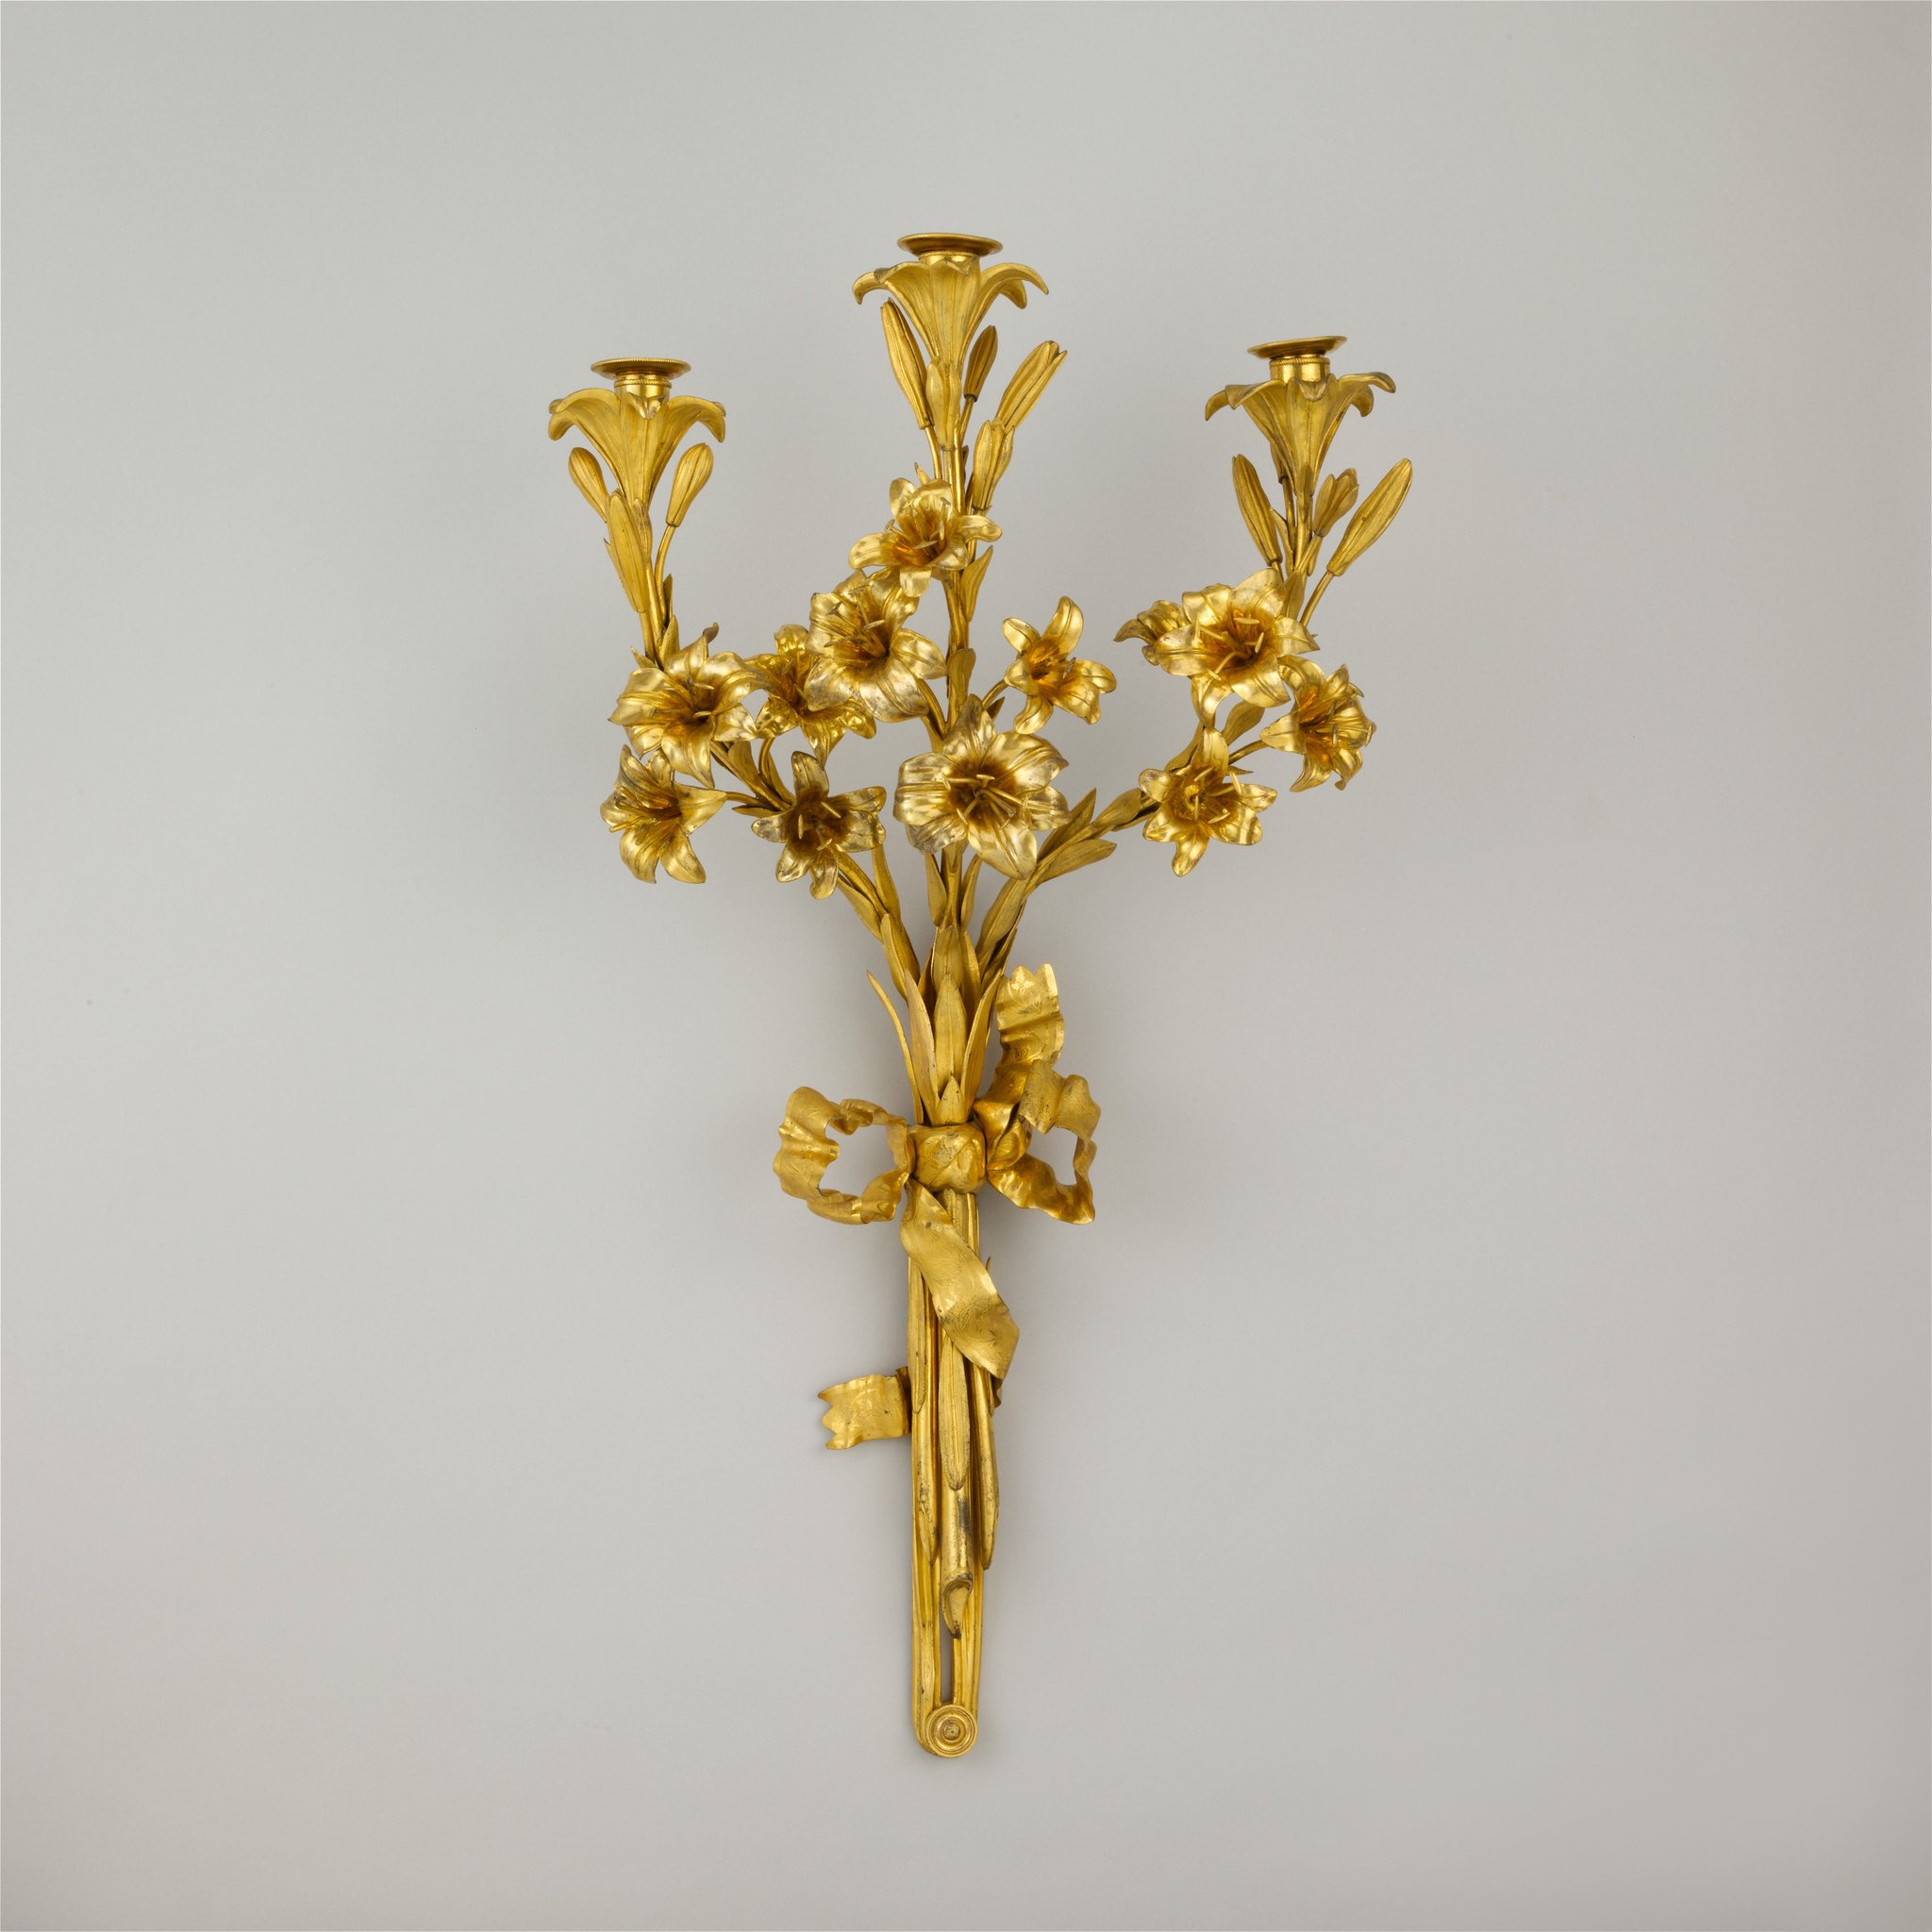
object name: sconce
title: Pair of three-light sconces (bras de lumière)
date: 1775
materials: gilt bronze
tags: flowers